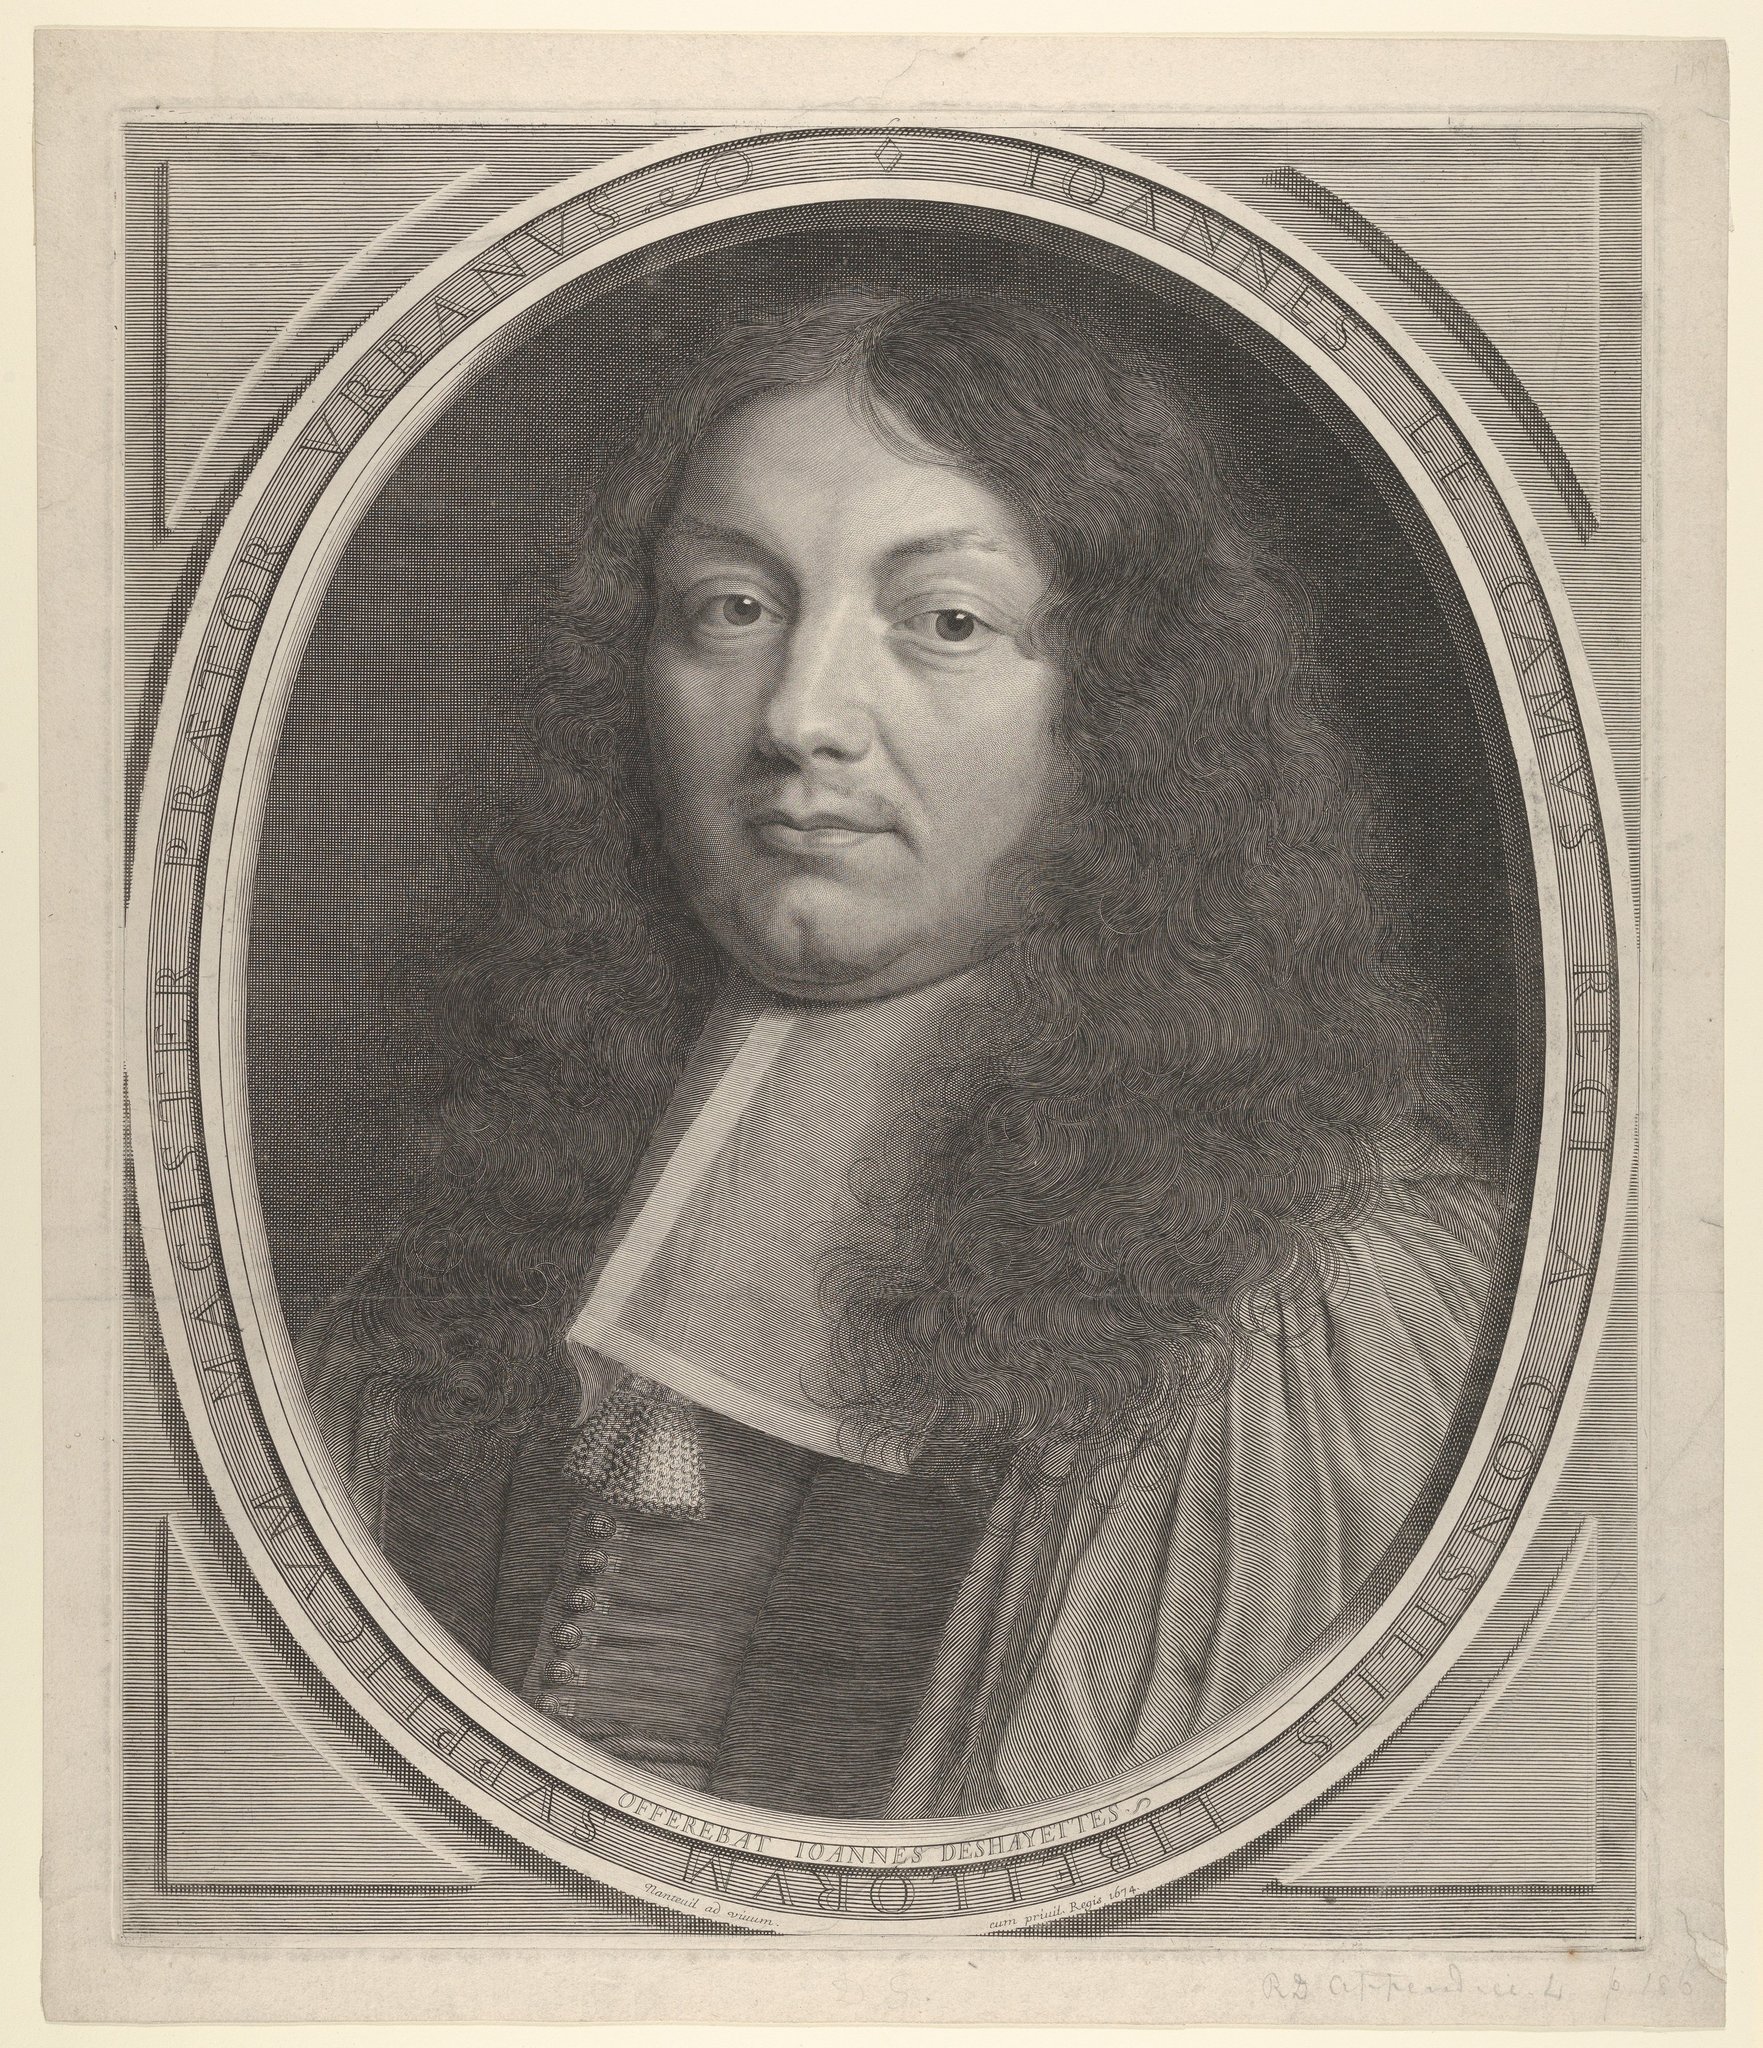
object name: print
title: Jean Le Camus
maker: robert nanteuil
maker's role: artist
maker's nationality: french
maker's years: 1623-1678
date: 1674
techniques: engraving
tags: men,portraits